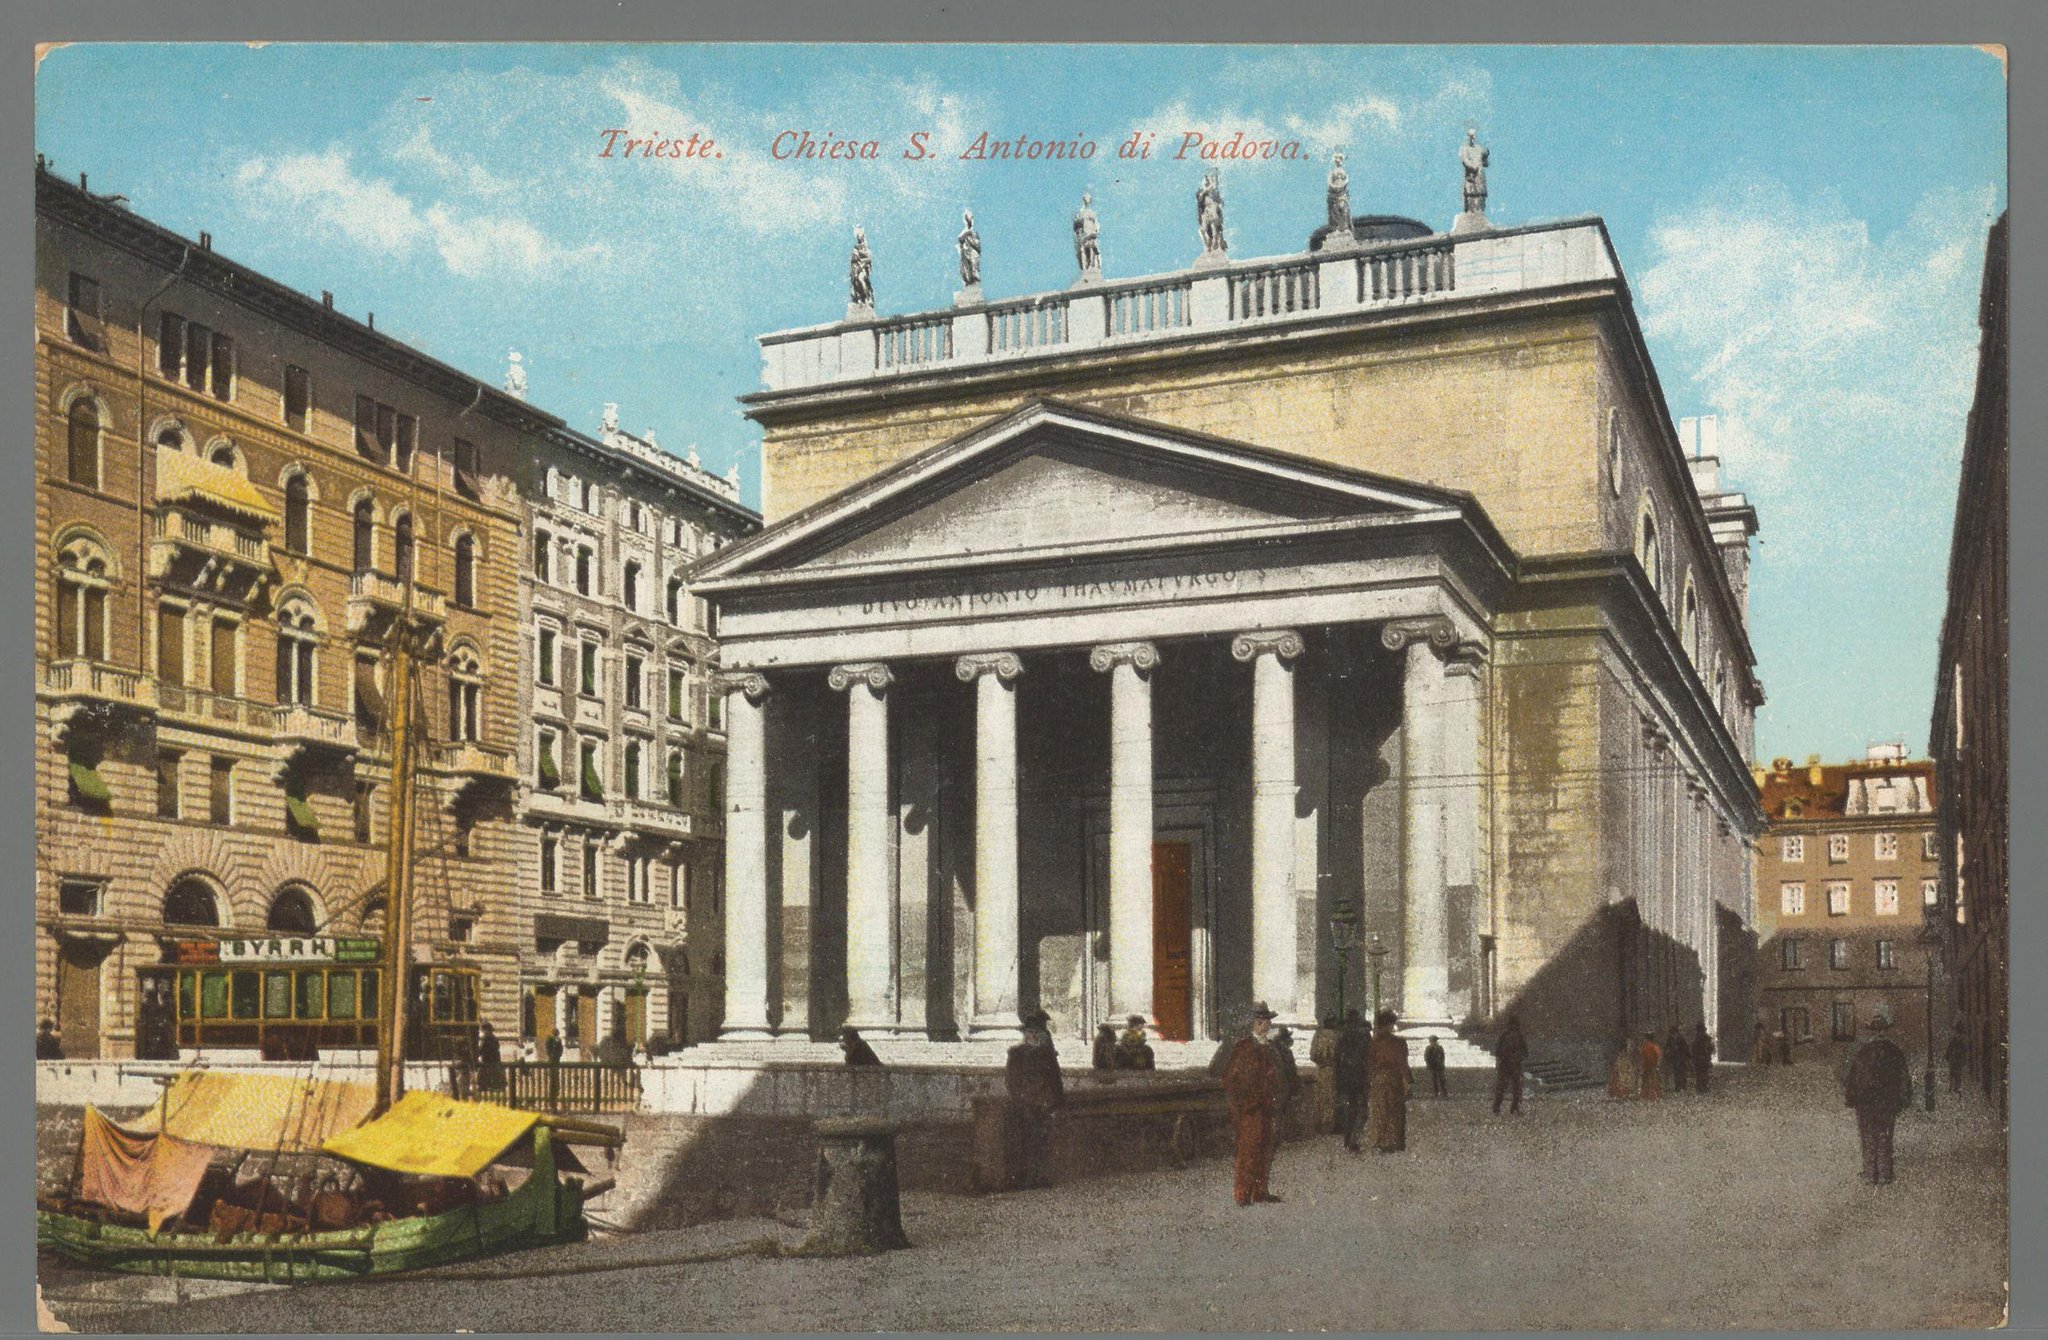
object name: ansichtkaart, prentbriefkaart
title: Trieste. Chiesa S. Antonio di Padova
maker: Anonymous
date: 1906-1909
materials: cardboard, photographic process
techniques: writing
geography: munich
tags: ships (in general), church (exterior), square, place, circus, etc. (+ city(-scape) with figures, staffage)